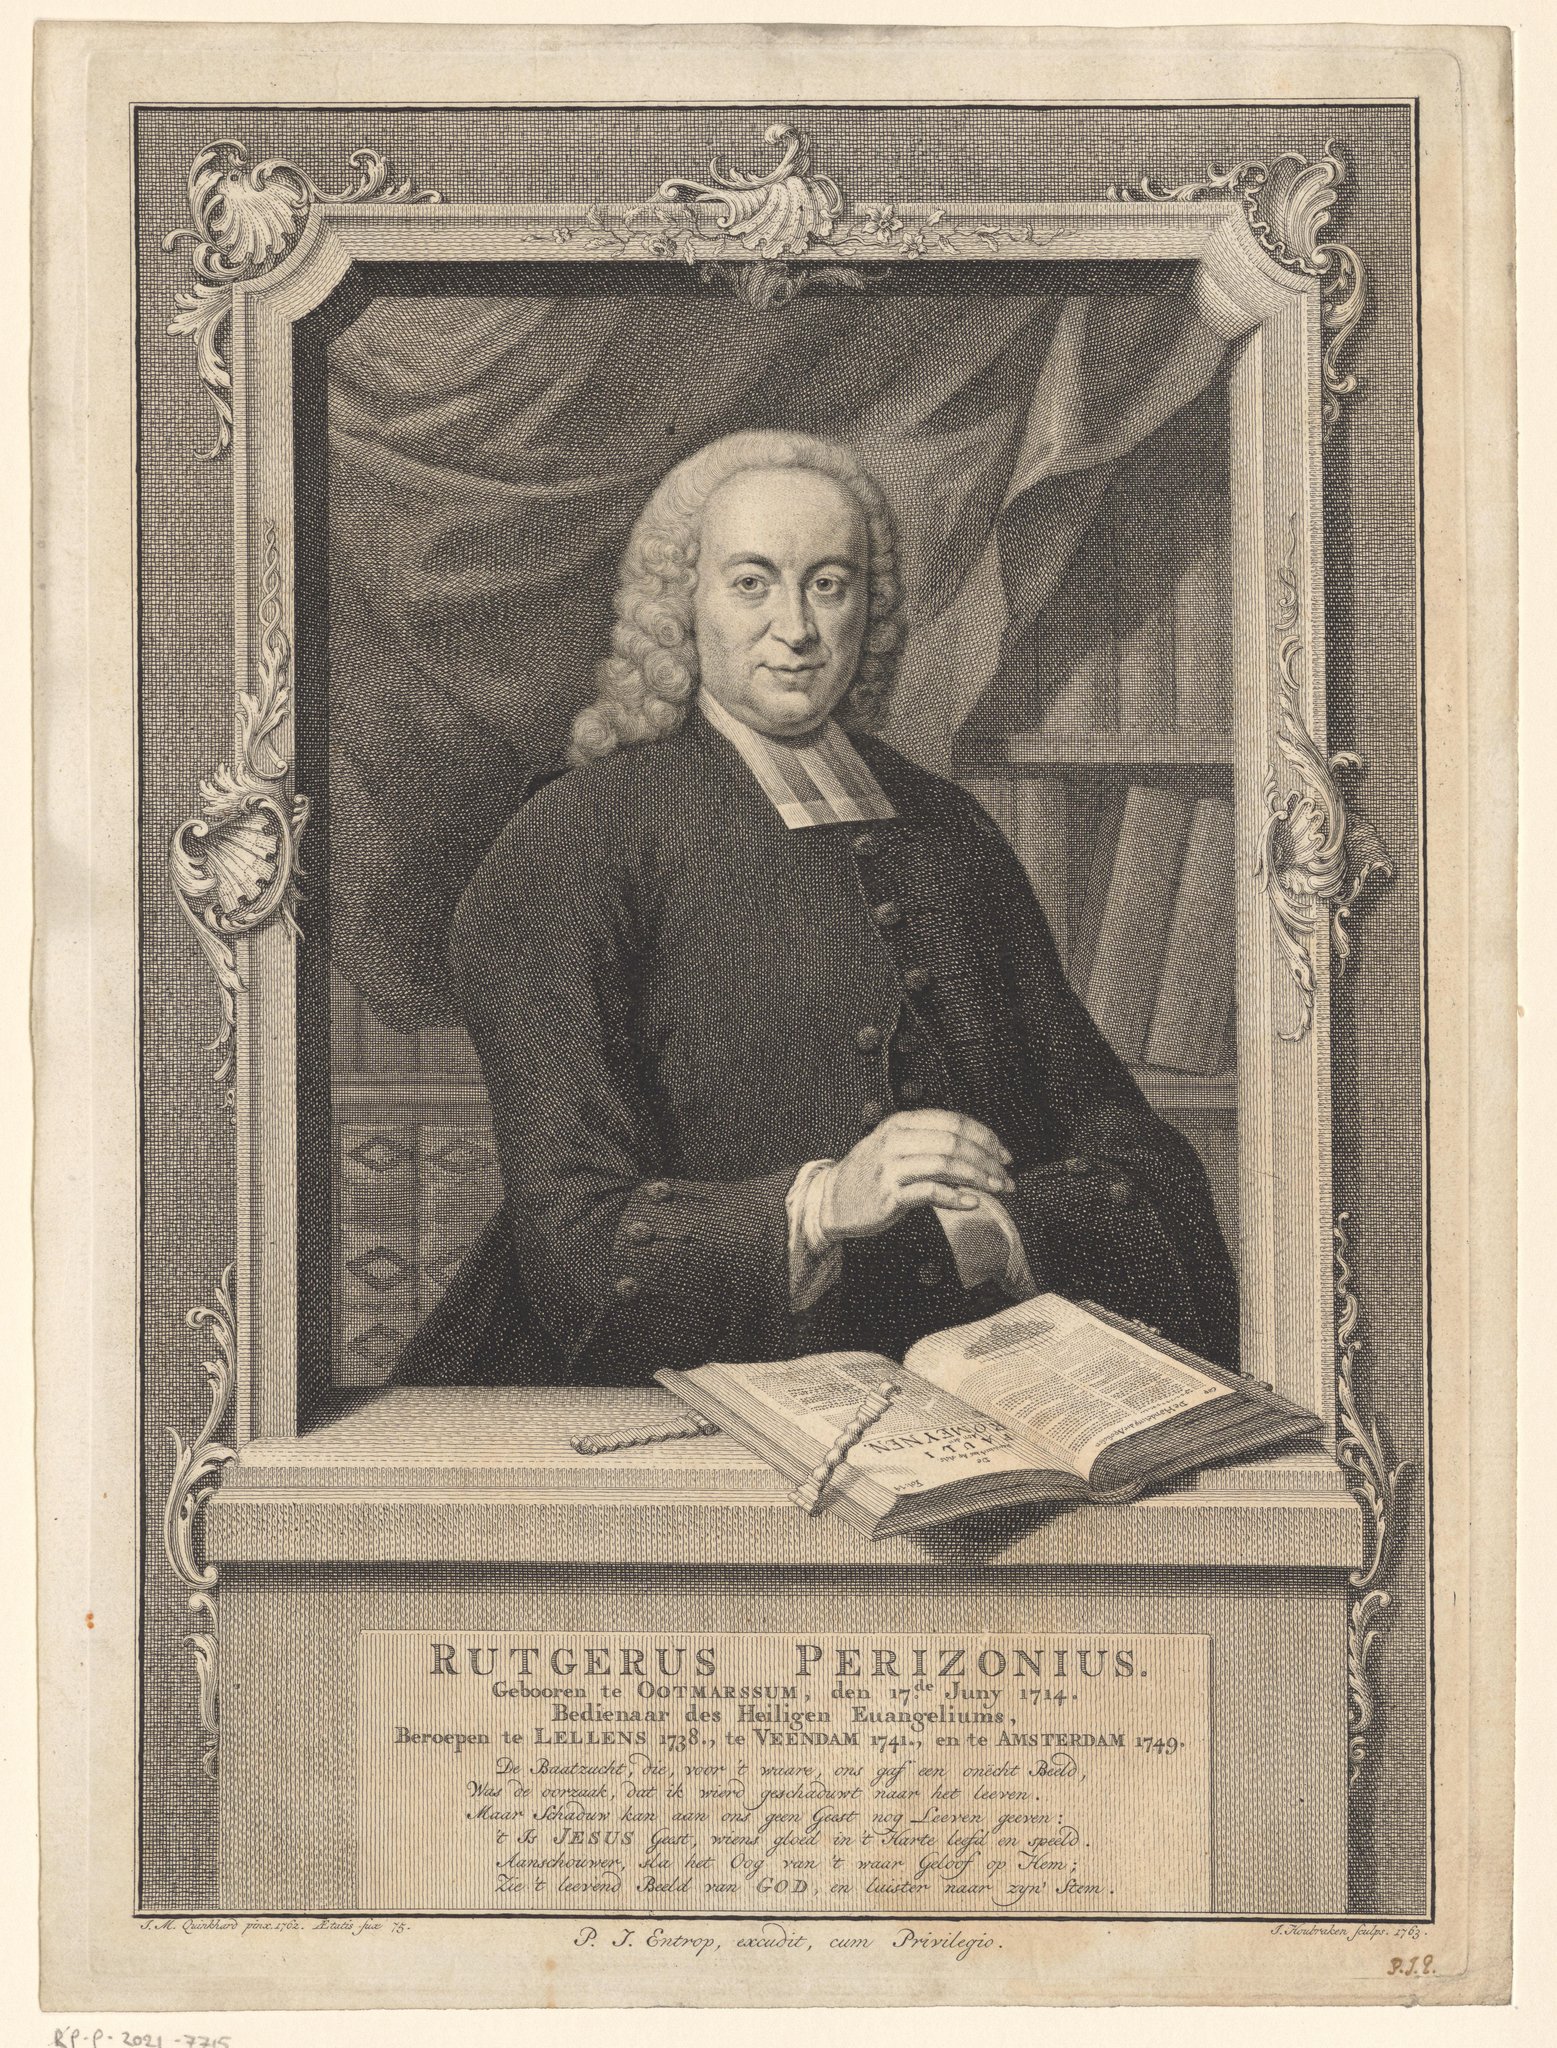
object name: print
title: Portret van Rutgerus Perizonius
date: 1763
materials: paper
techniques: engraving, etching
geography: amsterdam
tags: bookshelves, adult man, historical persons, book - mm - book open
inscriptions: collector's mark: Lugt 2228, inscription: ‘P.[I/J].8.’